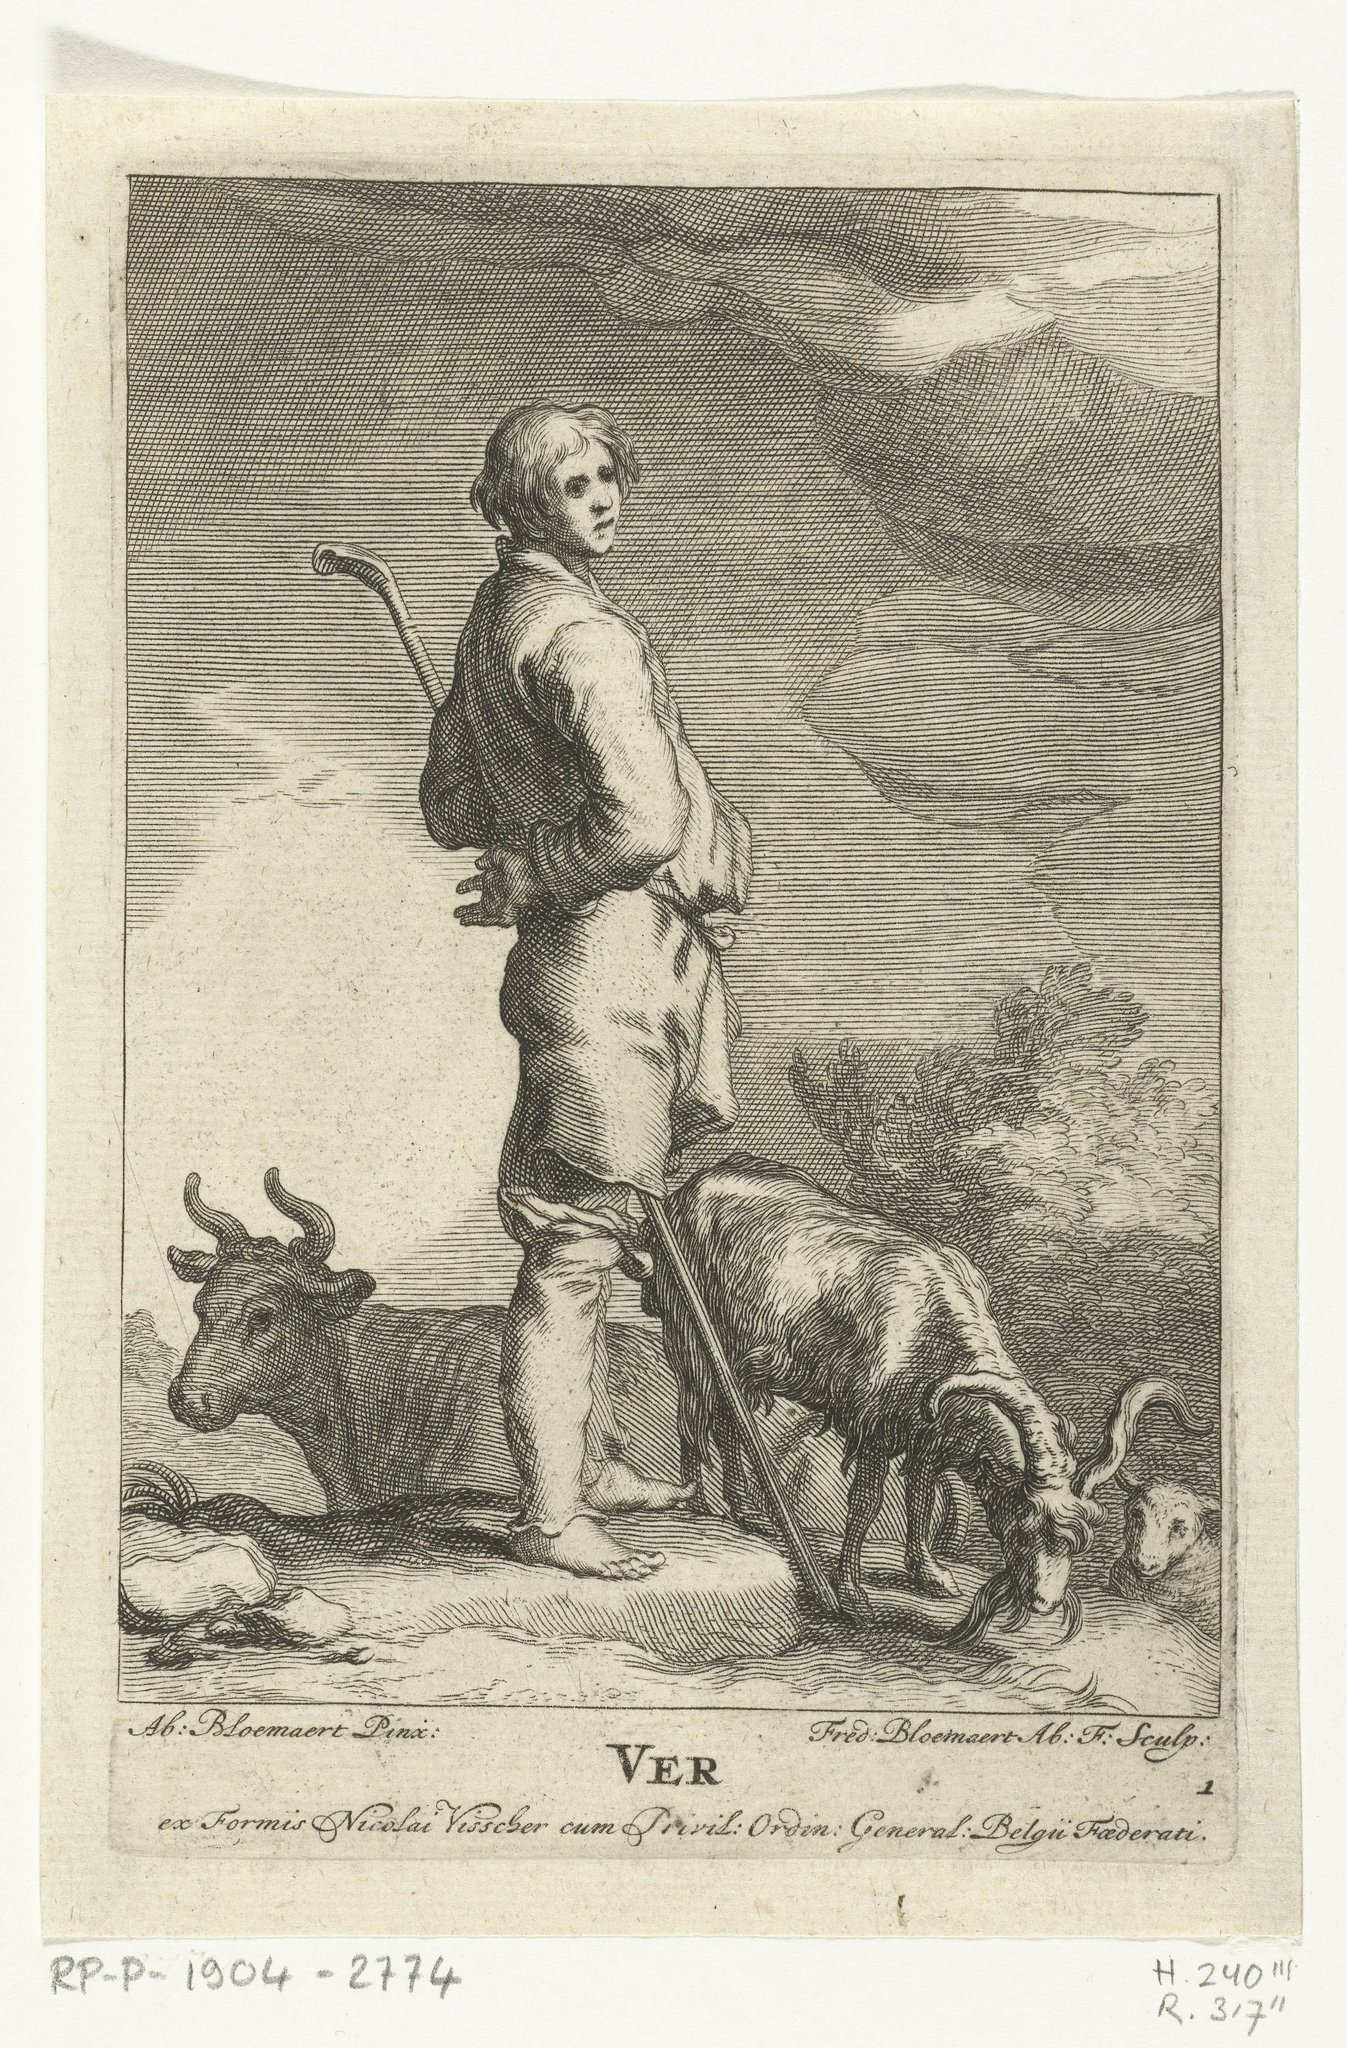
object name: print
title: De vier seizoenen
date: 1632-1670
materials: paper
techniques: engraving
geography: amsterdam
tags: spring, 'ver'; 'primavera' (ripa), herding, herdsman, herdswoman, shepherd, shepherdess, cowherd, etc.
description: Een veehoeder staat temidden van zijn rustende en grazende kudde.